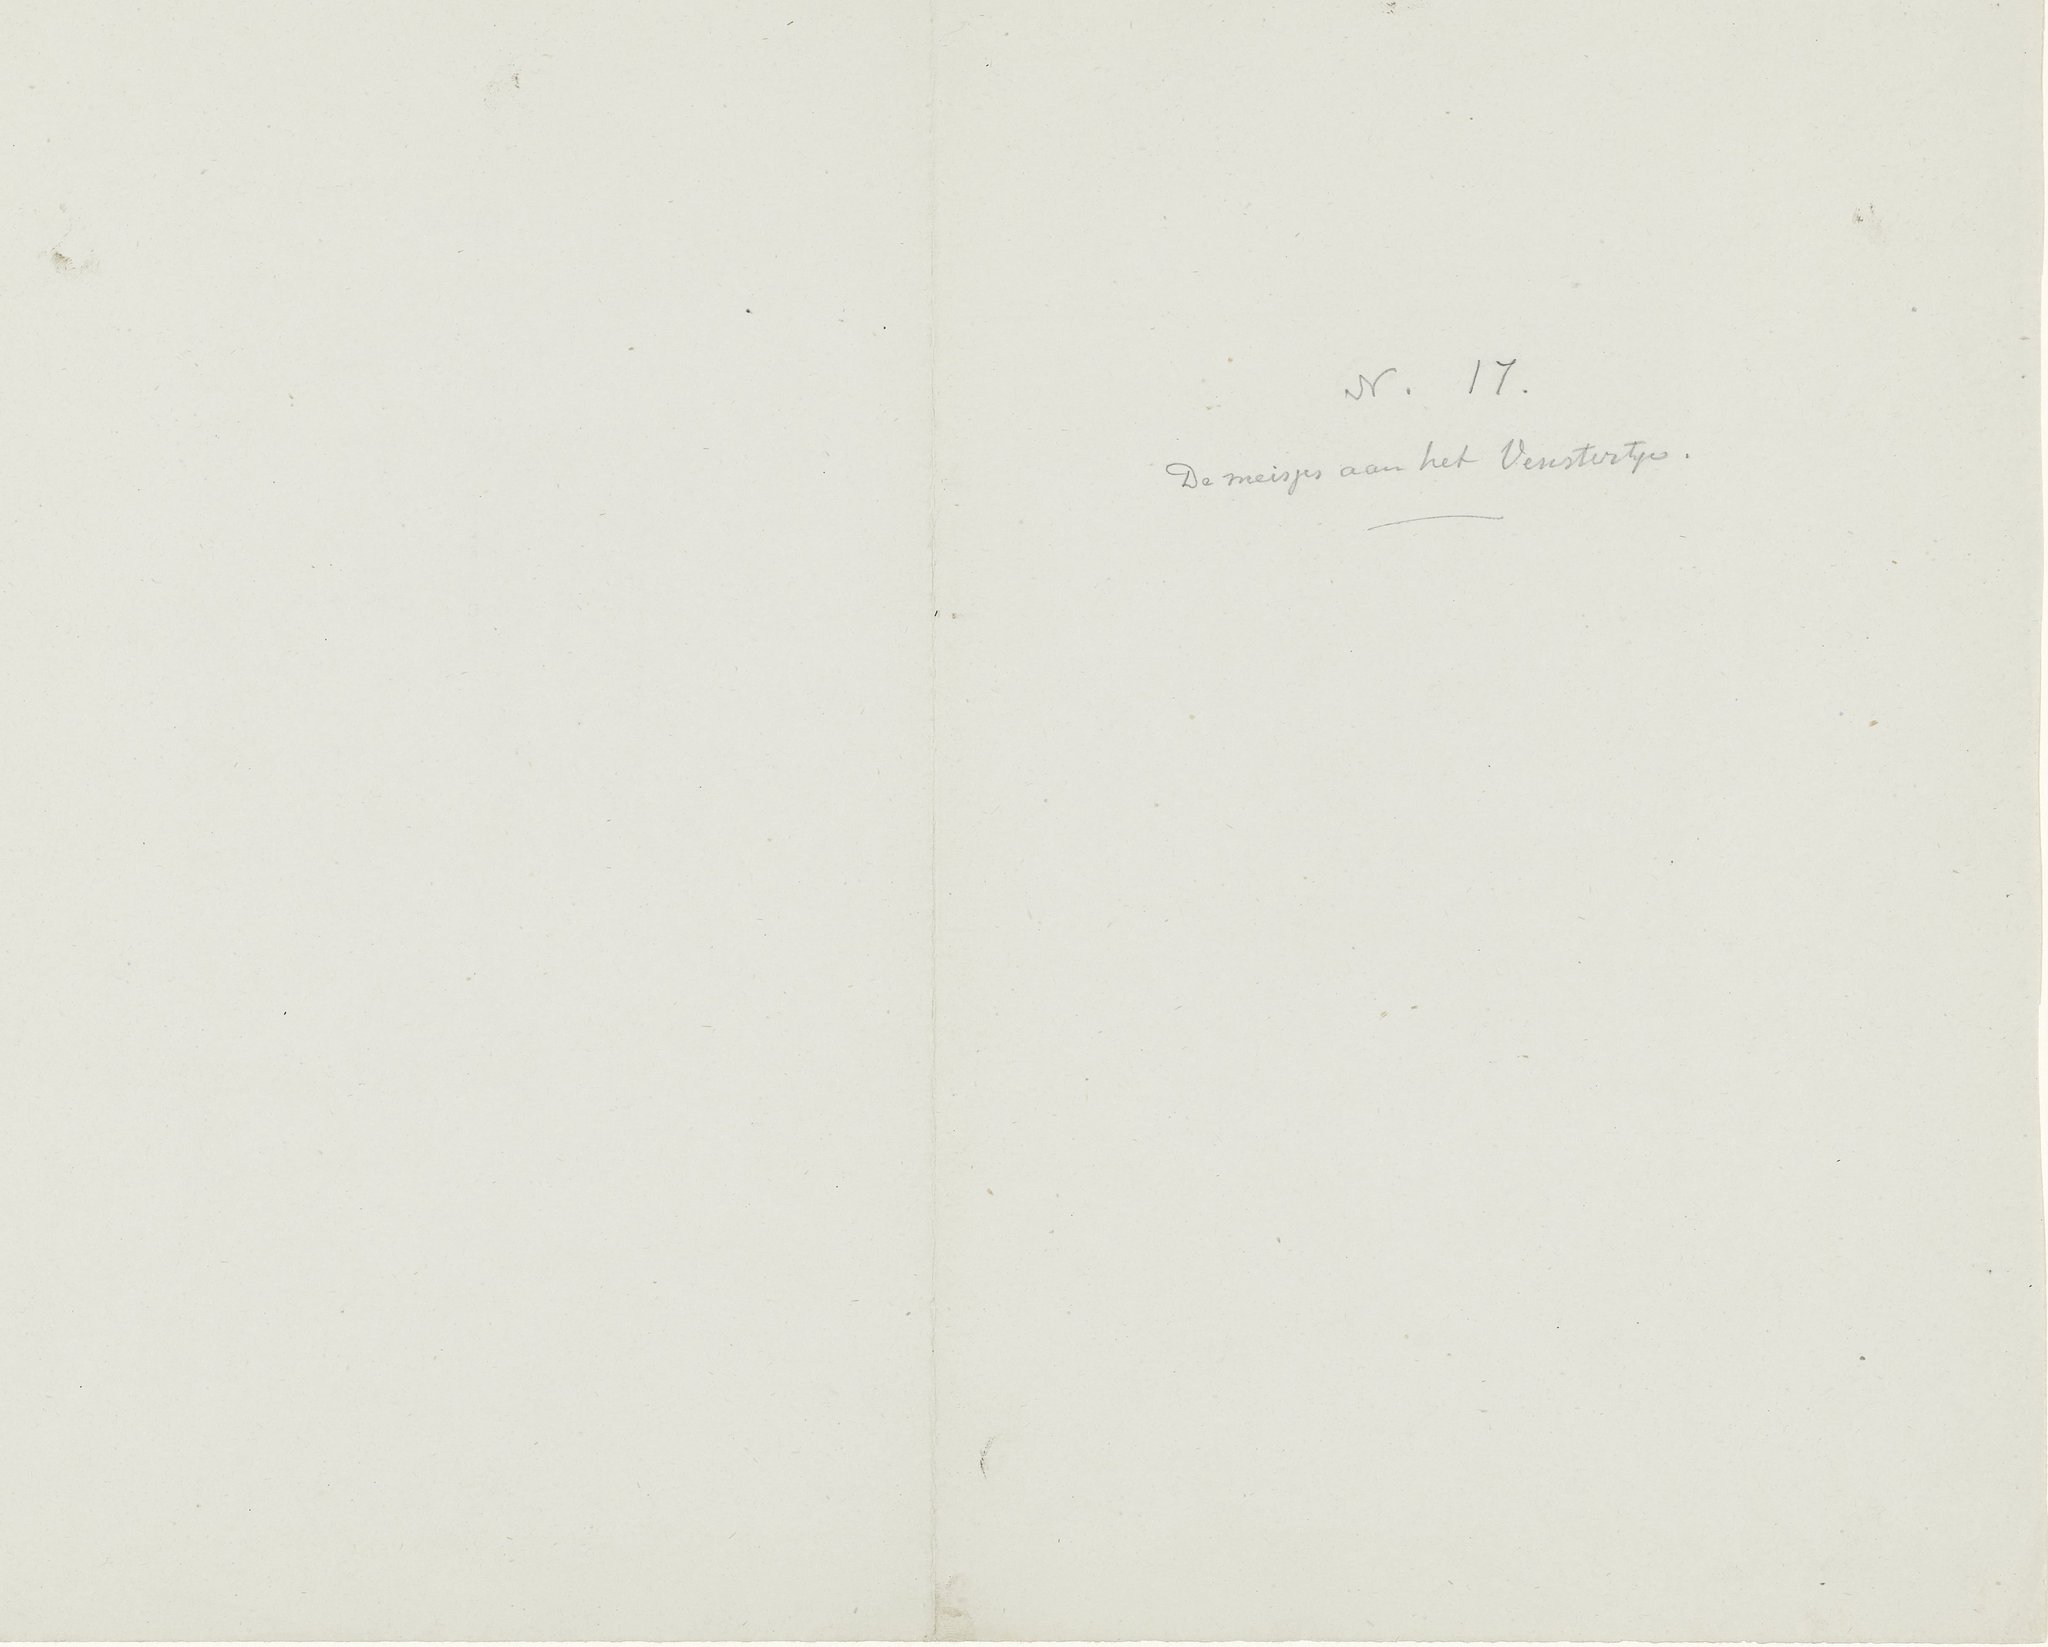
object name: wrapper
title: 17. De meisjes aan het Venstertje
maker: cornelis van der griendt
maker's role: draughtsman, painter, print maker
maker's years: 1827-1918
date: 1891-1918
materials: paper, pencil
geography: netherlands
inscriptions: inscription: ‘12 st’